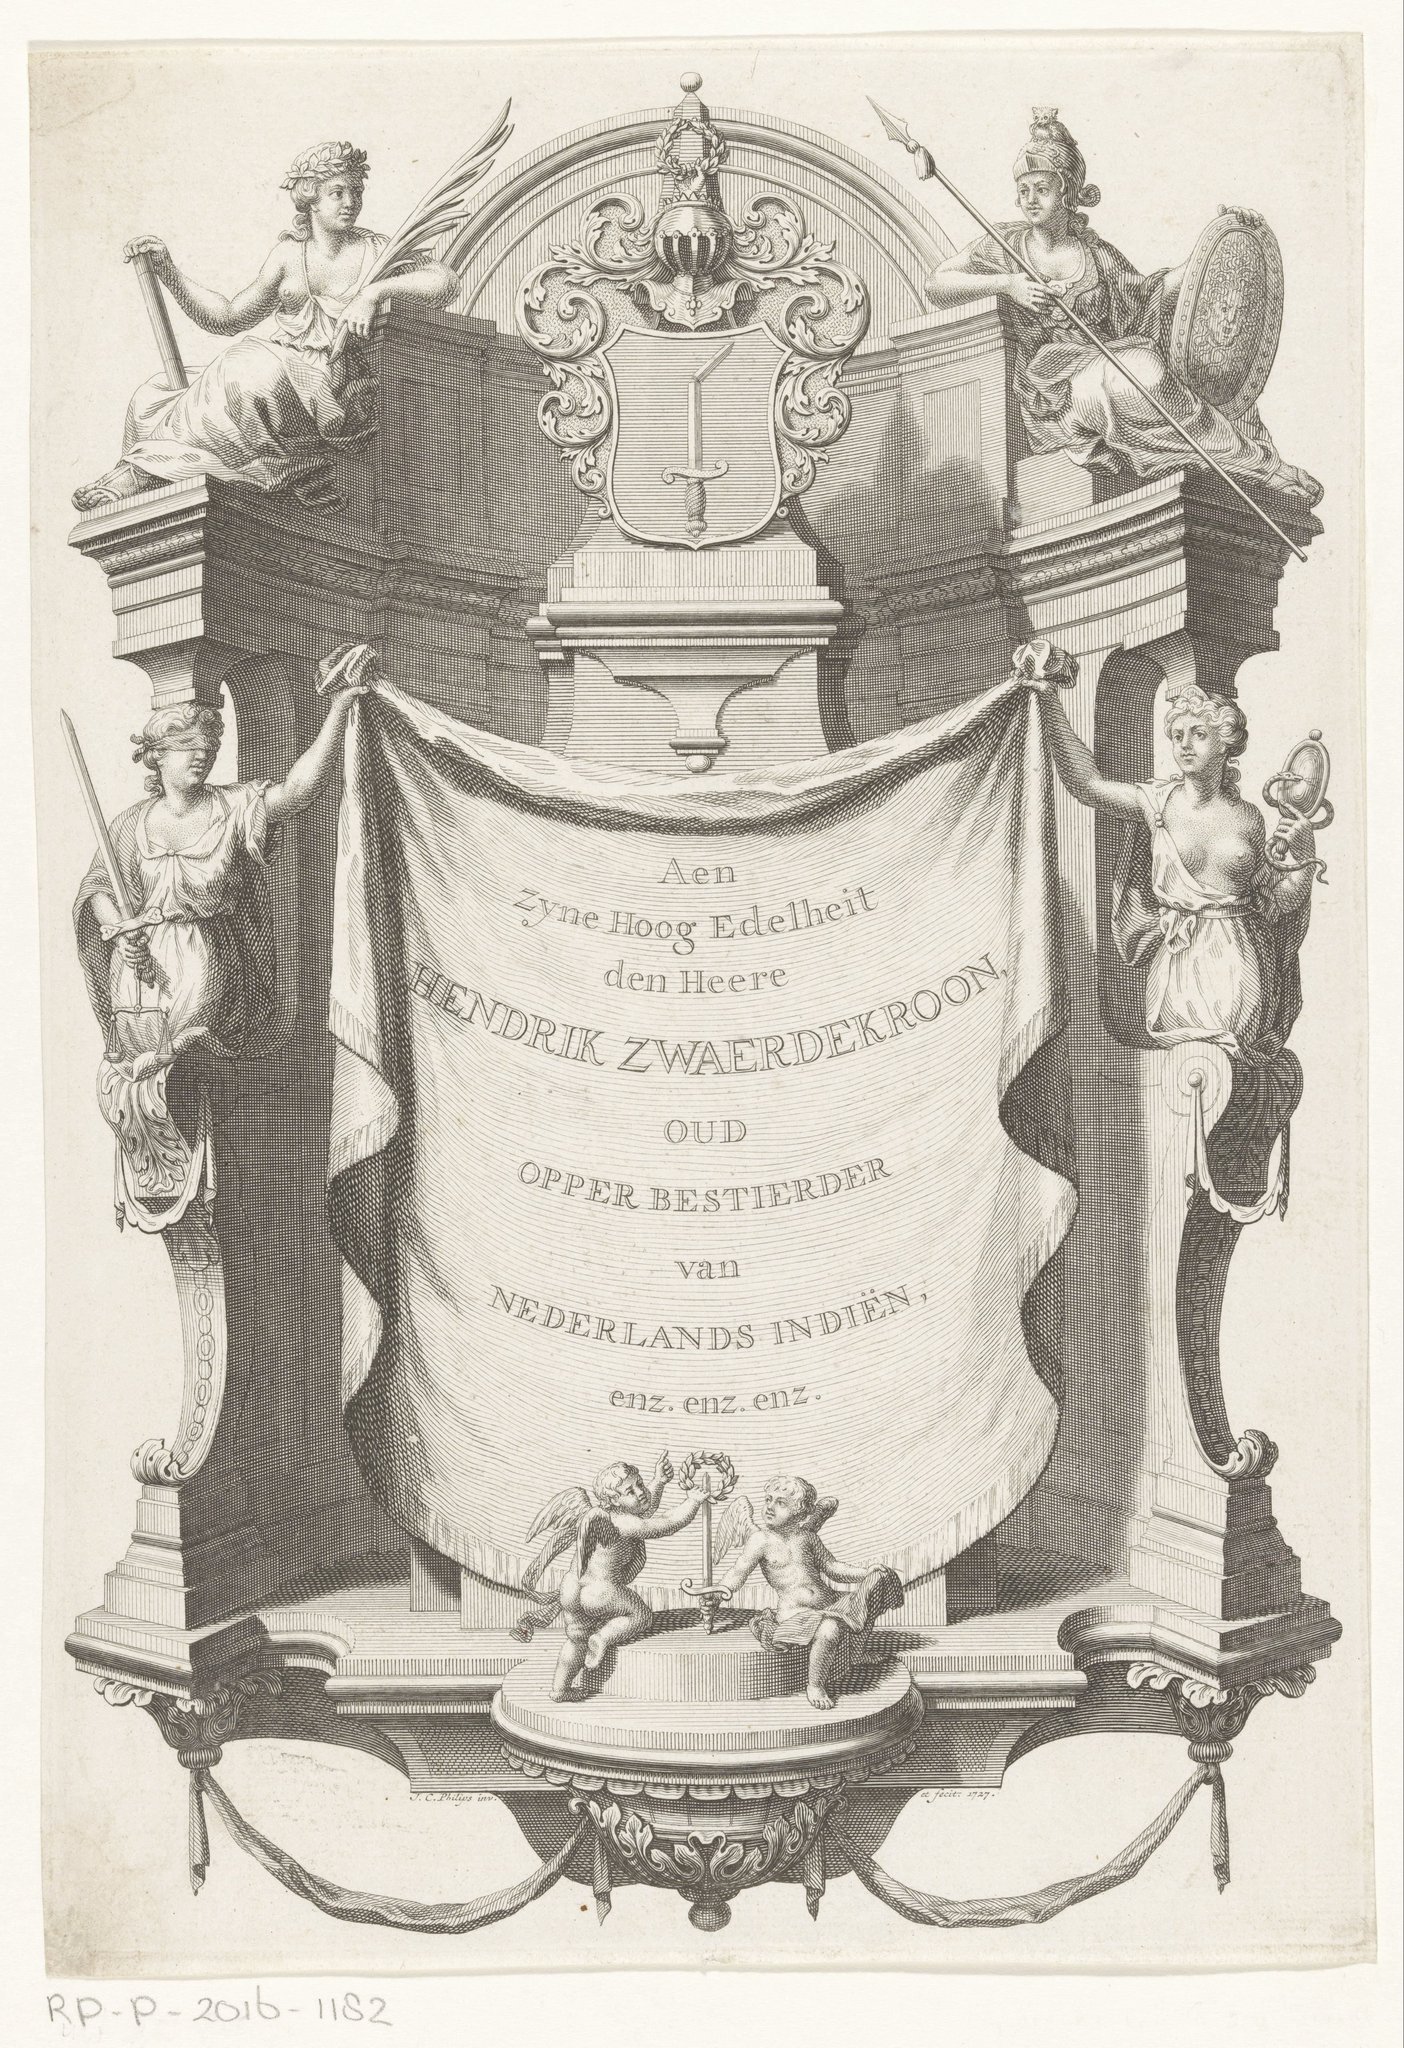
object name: book illustration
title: Opdracht met wapenschild van Hendrik Zwaerdekroon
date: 1727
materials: paper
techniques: engraving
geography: dordrecht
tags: rotterdam, batavia, henricus zwaardecroon, fortitude, 'fortitudo' ~ one of the four cardinal virtues, (story of) minerva (pallas, athena), justitia (justice) as roman personification, prudentia (prudence) as roman personification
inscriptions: collector's mark: Lugt 2228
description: Wapenschild van Hendrik Zwaerdekroon, gouverneur van Nederlands-Indië, gevat in een ornamentele omlijsting met Rechtvaardigheid (Justitia) en Voorzichtigheid (Prudentia). Zij houden een doek vast waarop een opdracht aan de gouverneur in het Nederlands. De omlijsting wordt bekroond door de personificatie van Kracht (Fortitudo) en Minerva.